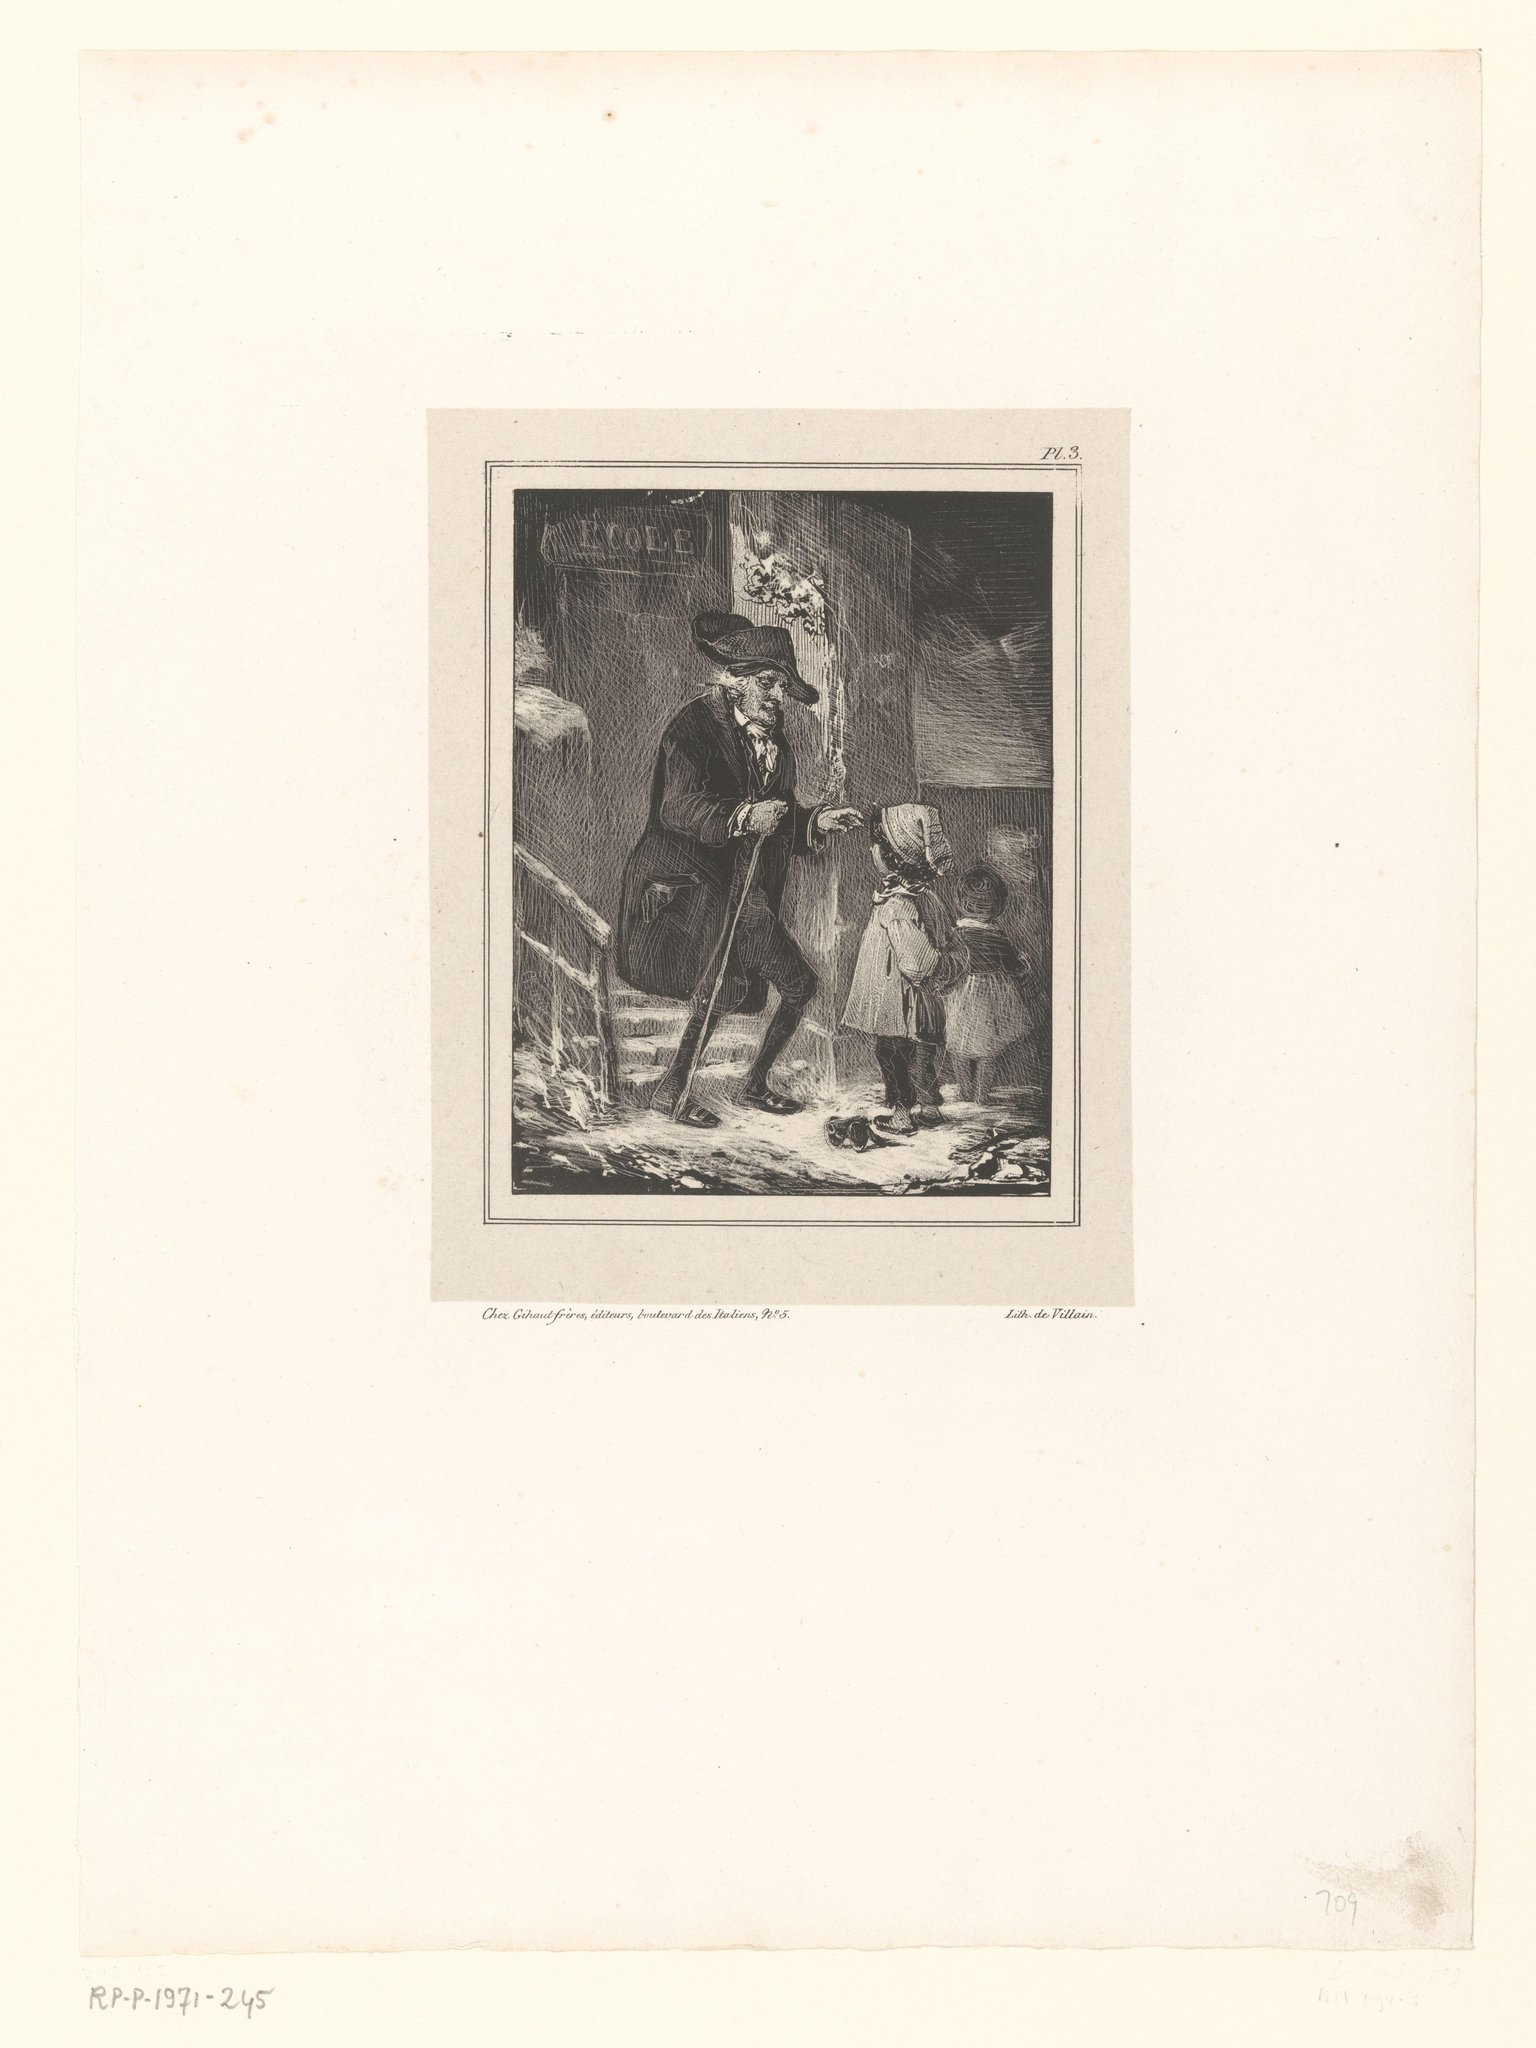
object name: print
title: Schetsen in inkt en mezzotint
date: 1828-1829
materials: paper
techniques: lithograph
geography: paris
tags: child and school (~ games and plays), teacher and pupil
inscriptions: collector's mark: Lugt 2228a, collector's mark: Lugt 2760